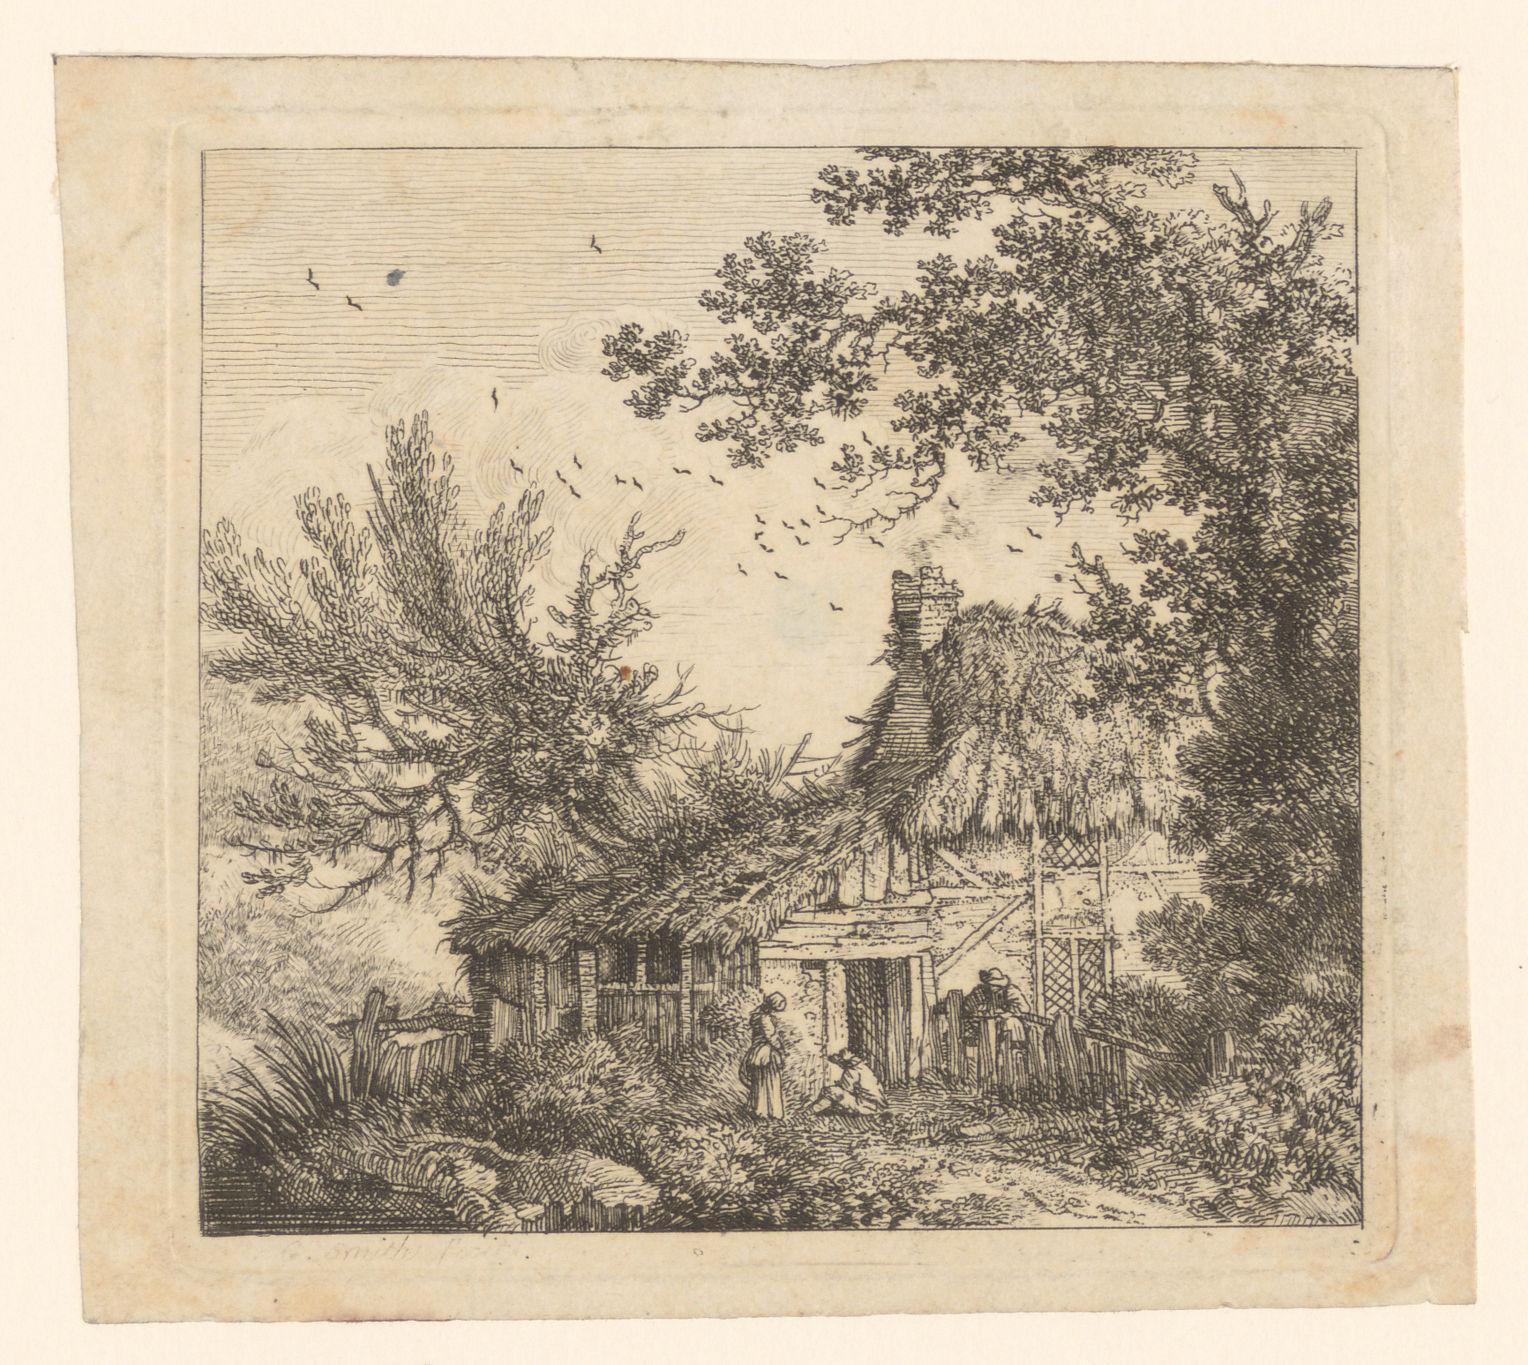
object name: print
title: Drieënvijftig kleine landschappen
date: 1770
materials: paper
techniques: etching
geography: great britain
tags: cottage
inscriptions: collector's mark: Lugt 2228, collector's mark: Lugt 2760